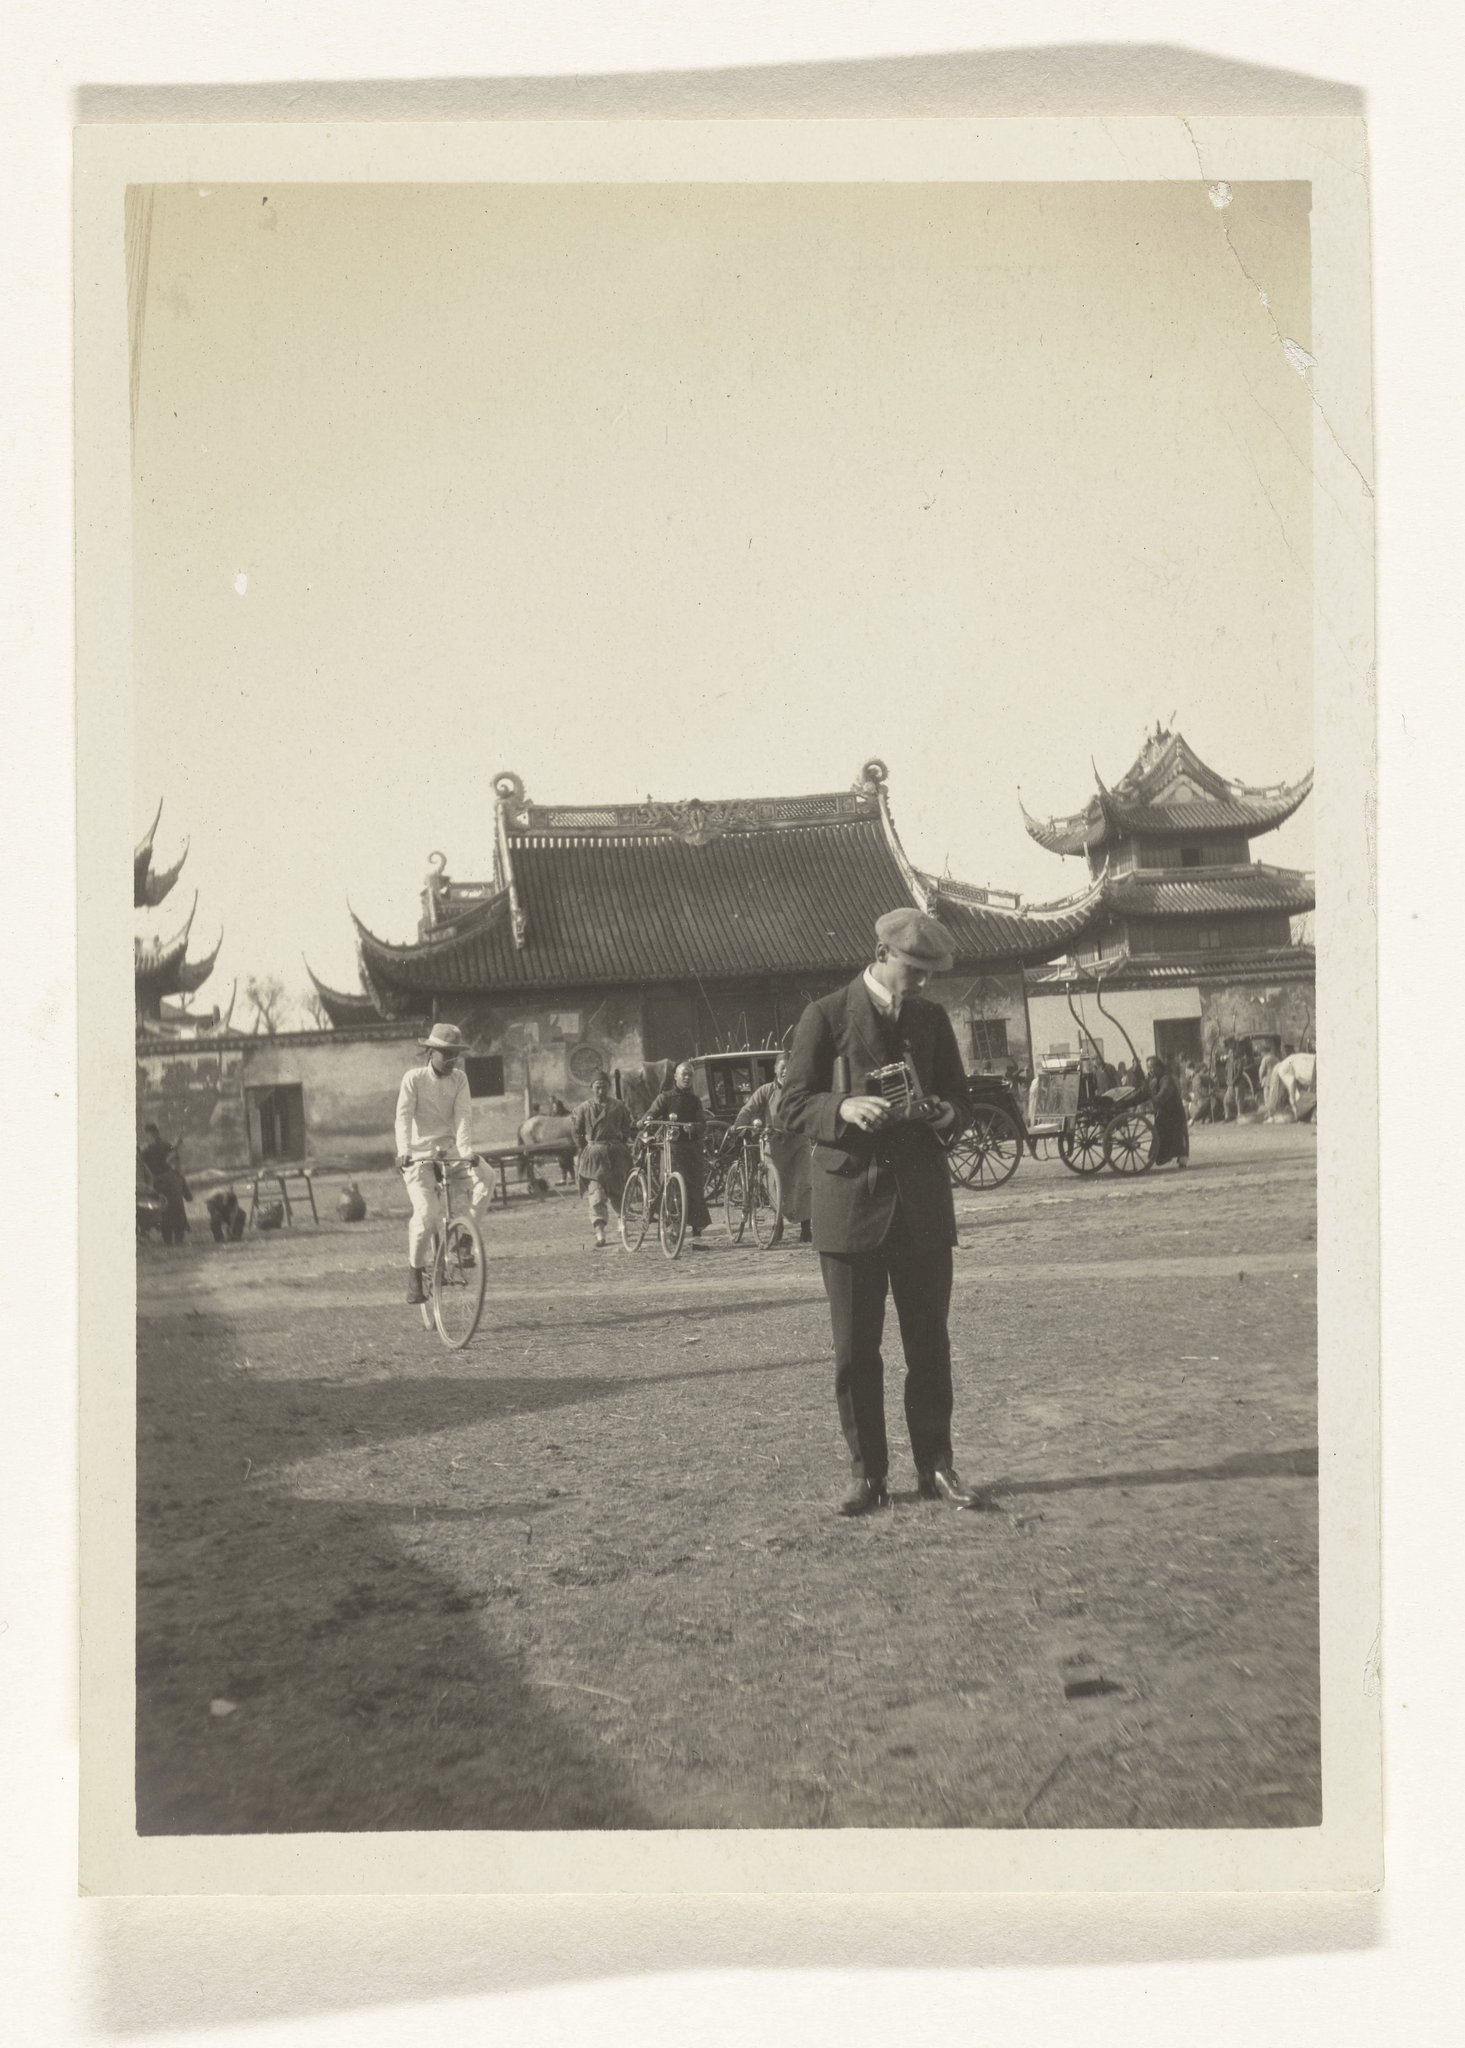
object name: photograph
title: Loongwa temple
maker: geldolph adriaan kessler (dolph)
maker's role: fotograaf, industrieel, voetballer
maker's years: 1884-1945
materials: cardboard, photographic support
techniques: gelatin silver print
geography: shanghai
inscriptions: title: ‘Loongwa temple’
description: Dolph Kessler of reisgenoot met een camera op het plein voor het Boedhistische tempelcomplex Longhua in Shanghai. Onderdeel van het fotoalbum van Dolph Kessler met opnamen die hij maakte tijdens zijn verblijf in Engeland en op een wereldreis die hij als secretaris van Henri Deterding (directeur Koninklijke Olie) ondernam naar Nederlands-Indië, Japan, China en de Verenigde Staten, tussen 1906 en 1908.